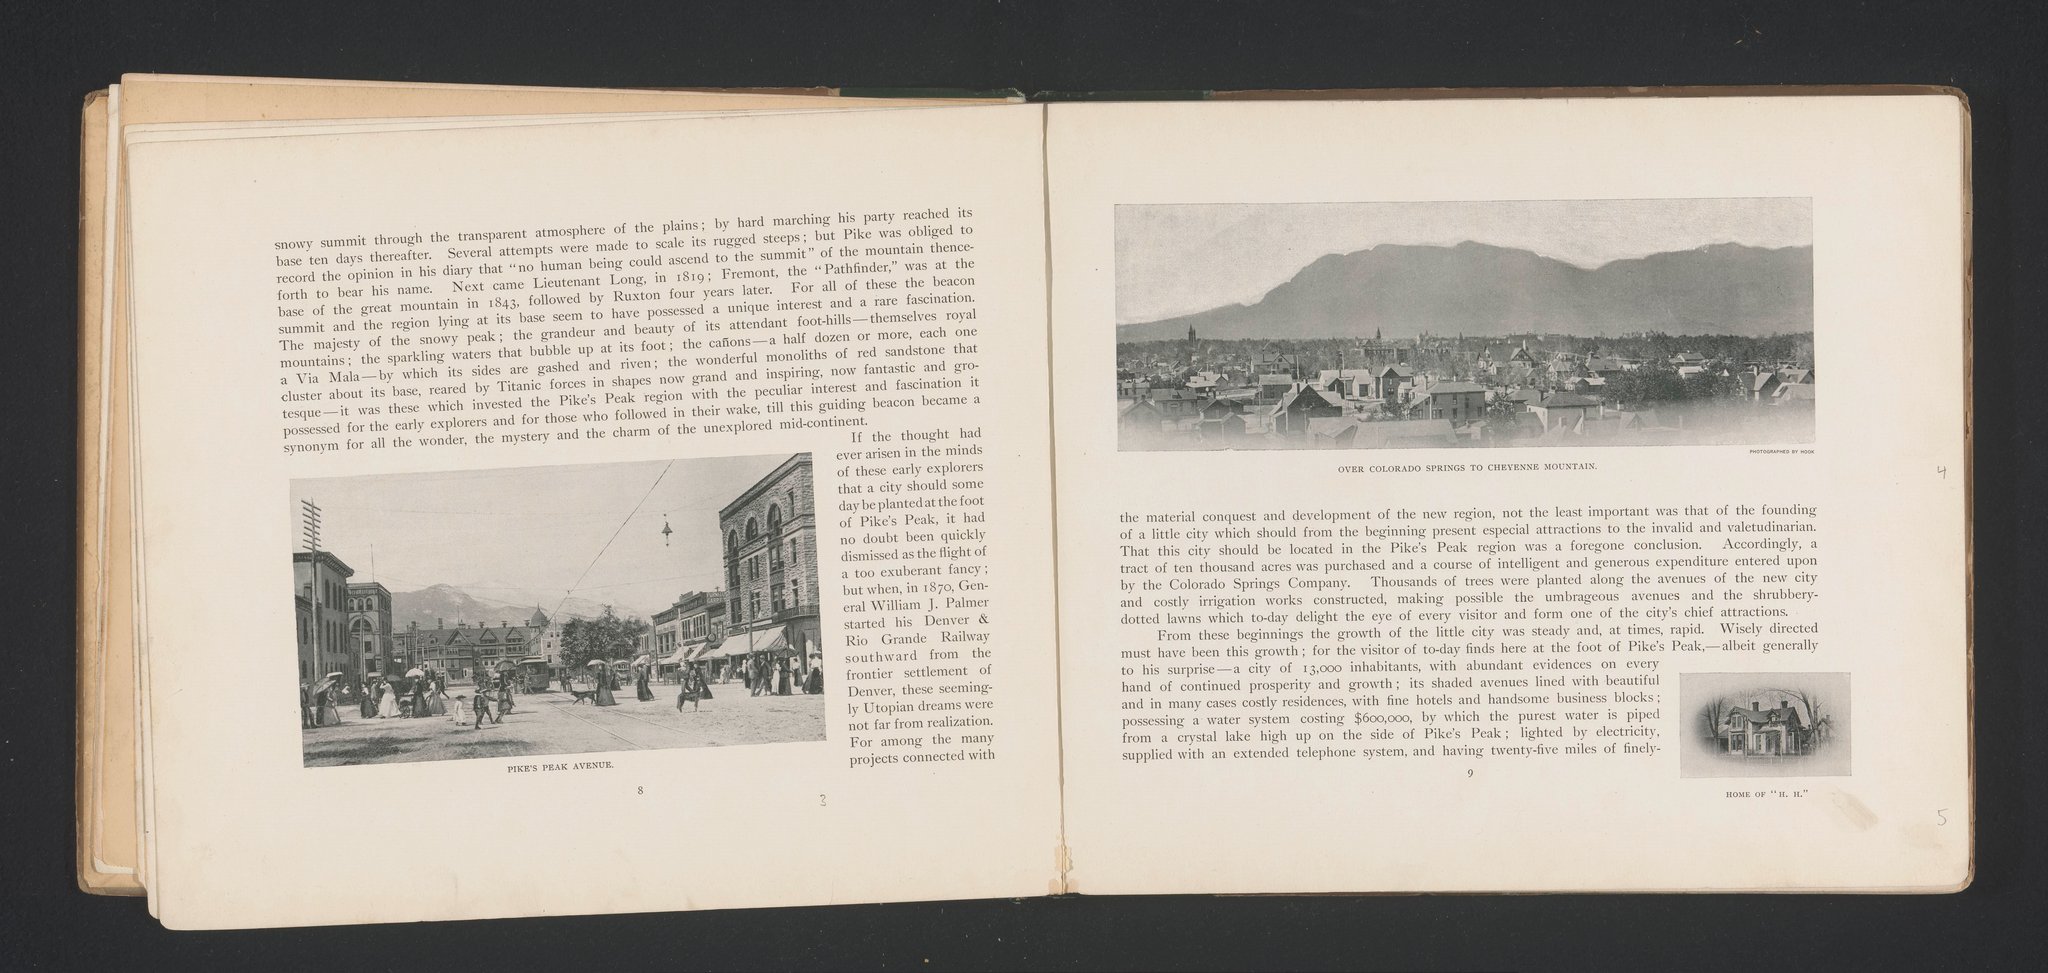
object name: photomechanical print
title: Home of H.H.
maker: Anonymous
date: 1888-1893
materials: paper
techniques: autotype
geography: colorado springs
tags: façade (of house or building)